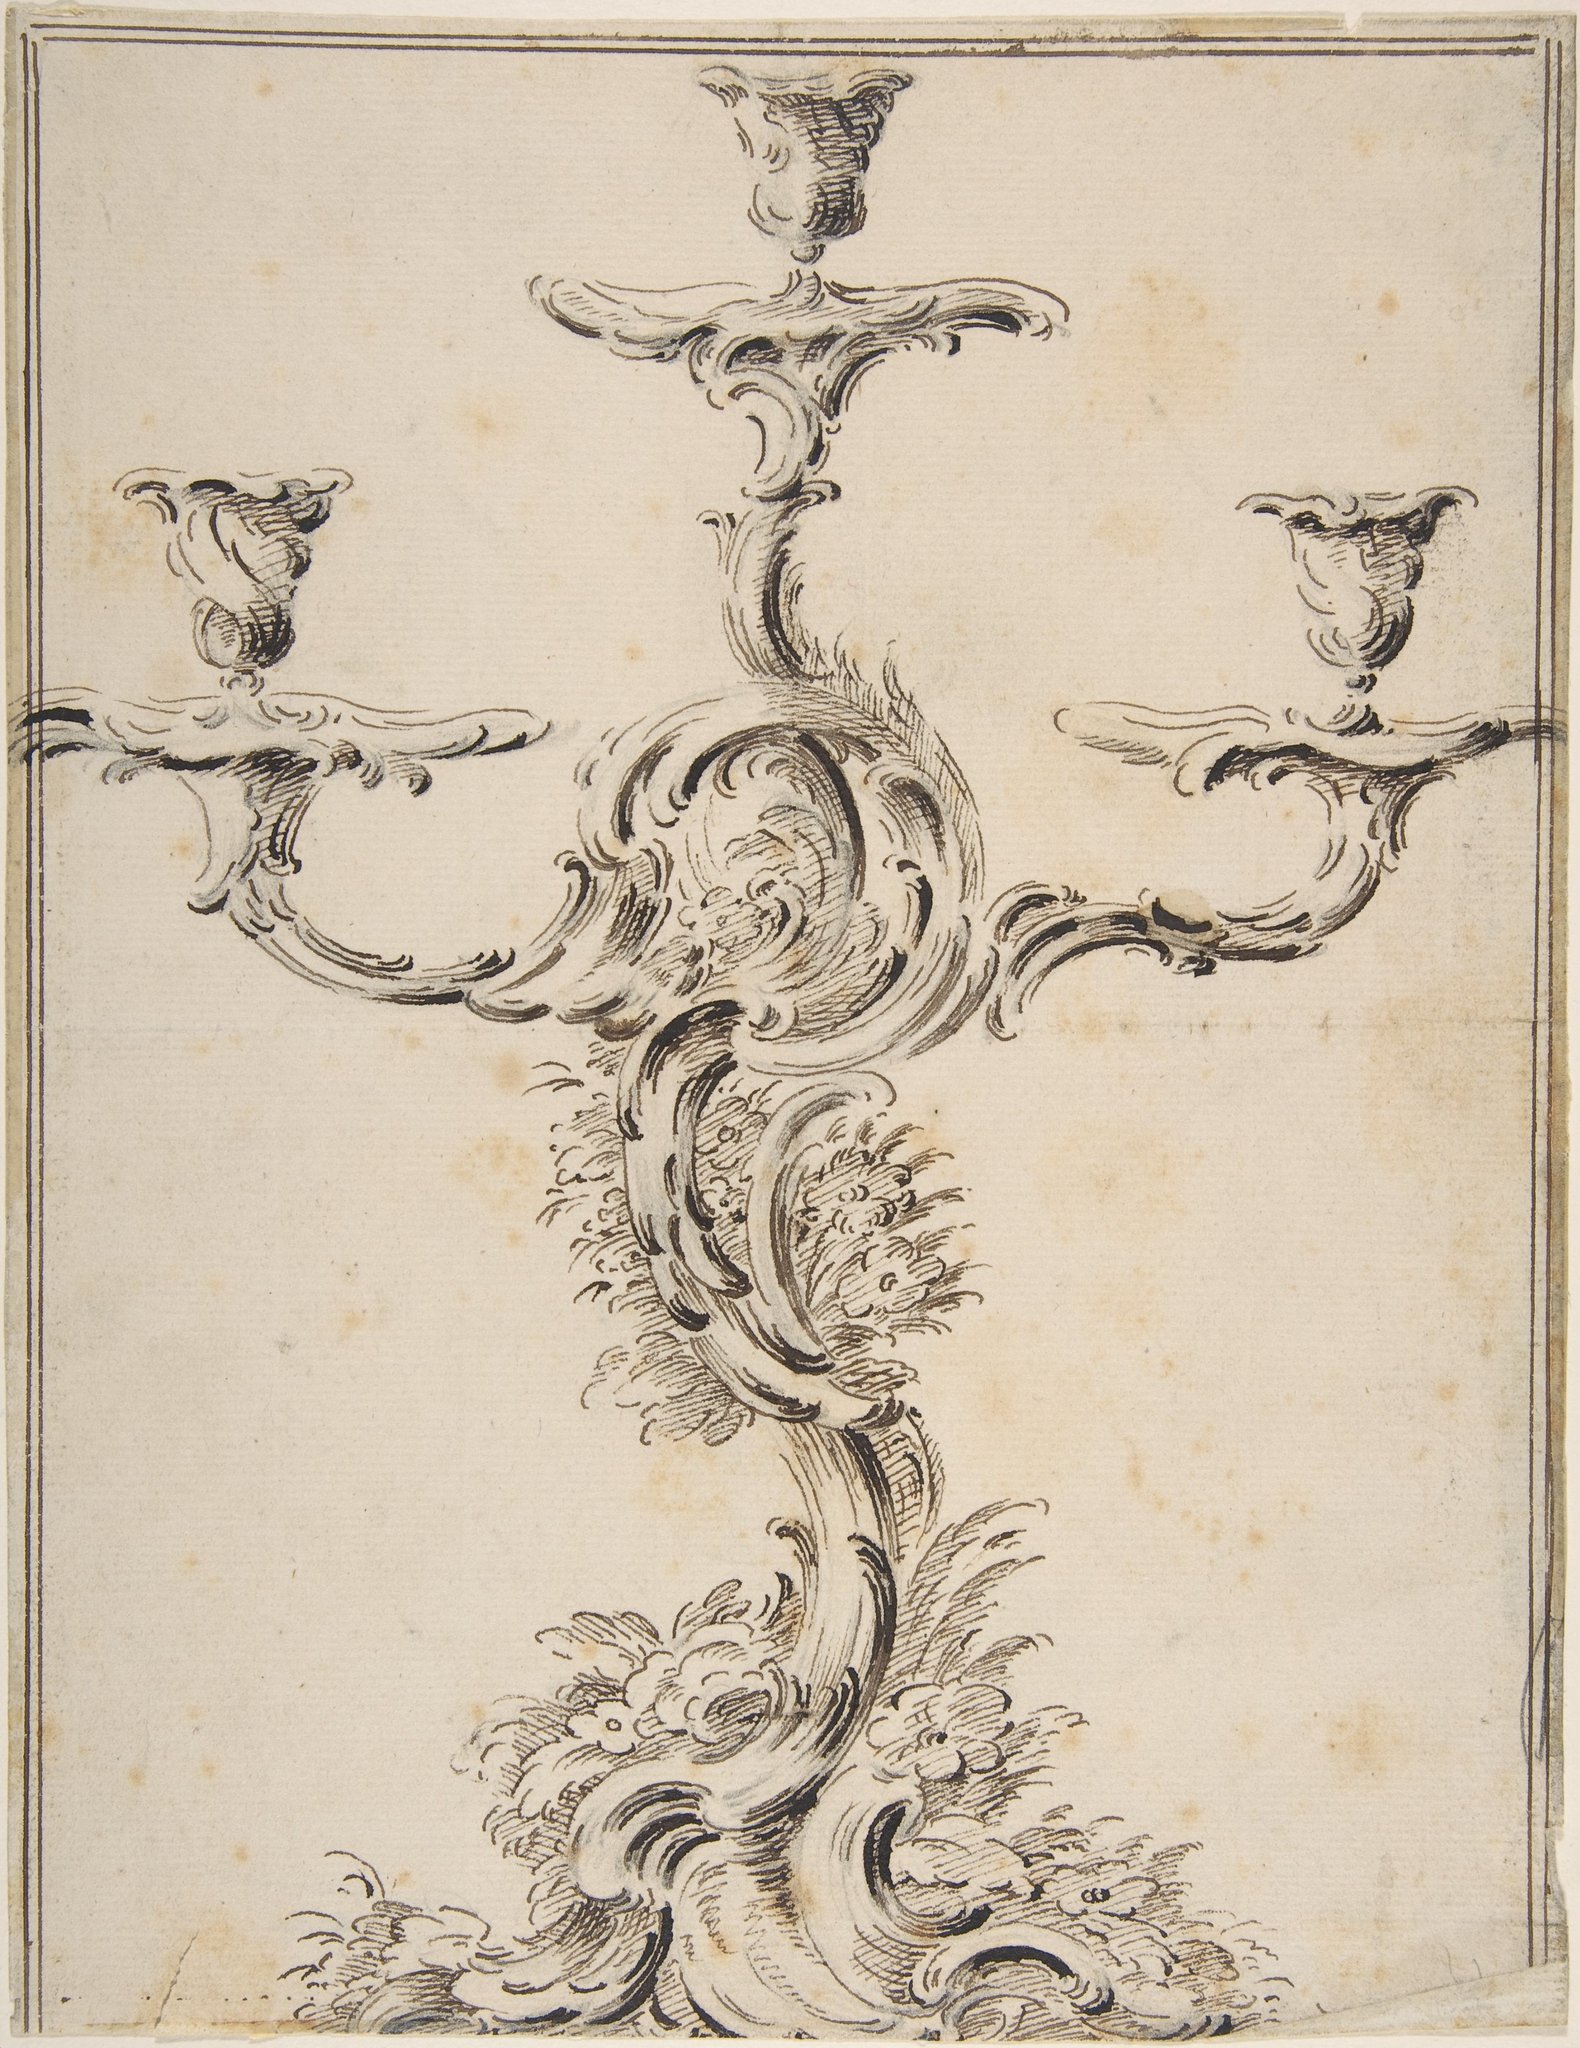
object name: drawing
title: Design for a Candelabra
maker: anonymous, french, 18th century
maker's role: artist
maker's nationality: french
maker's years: 1700-1800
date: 1701-1800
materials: ink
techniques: pen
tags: candelabra